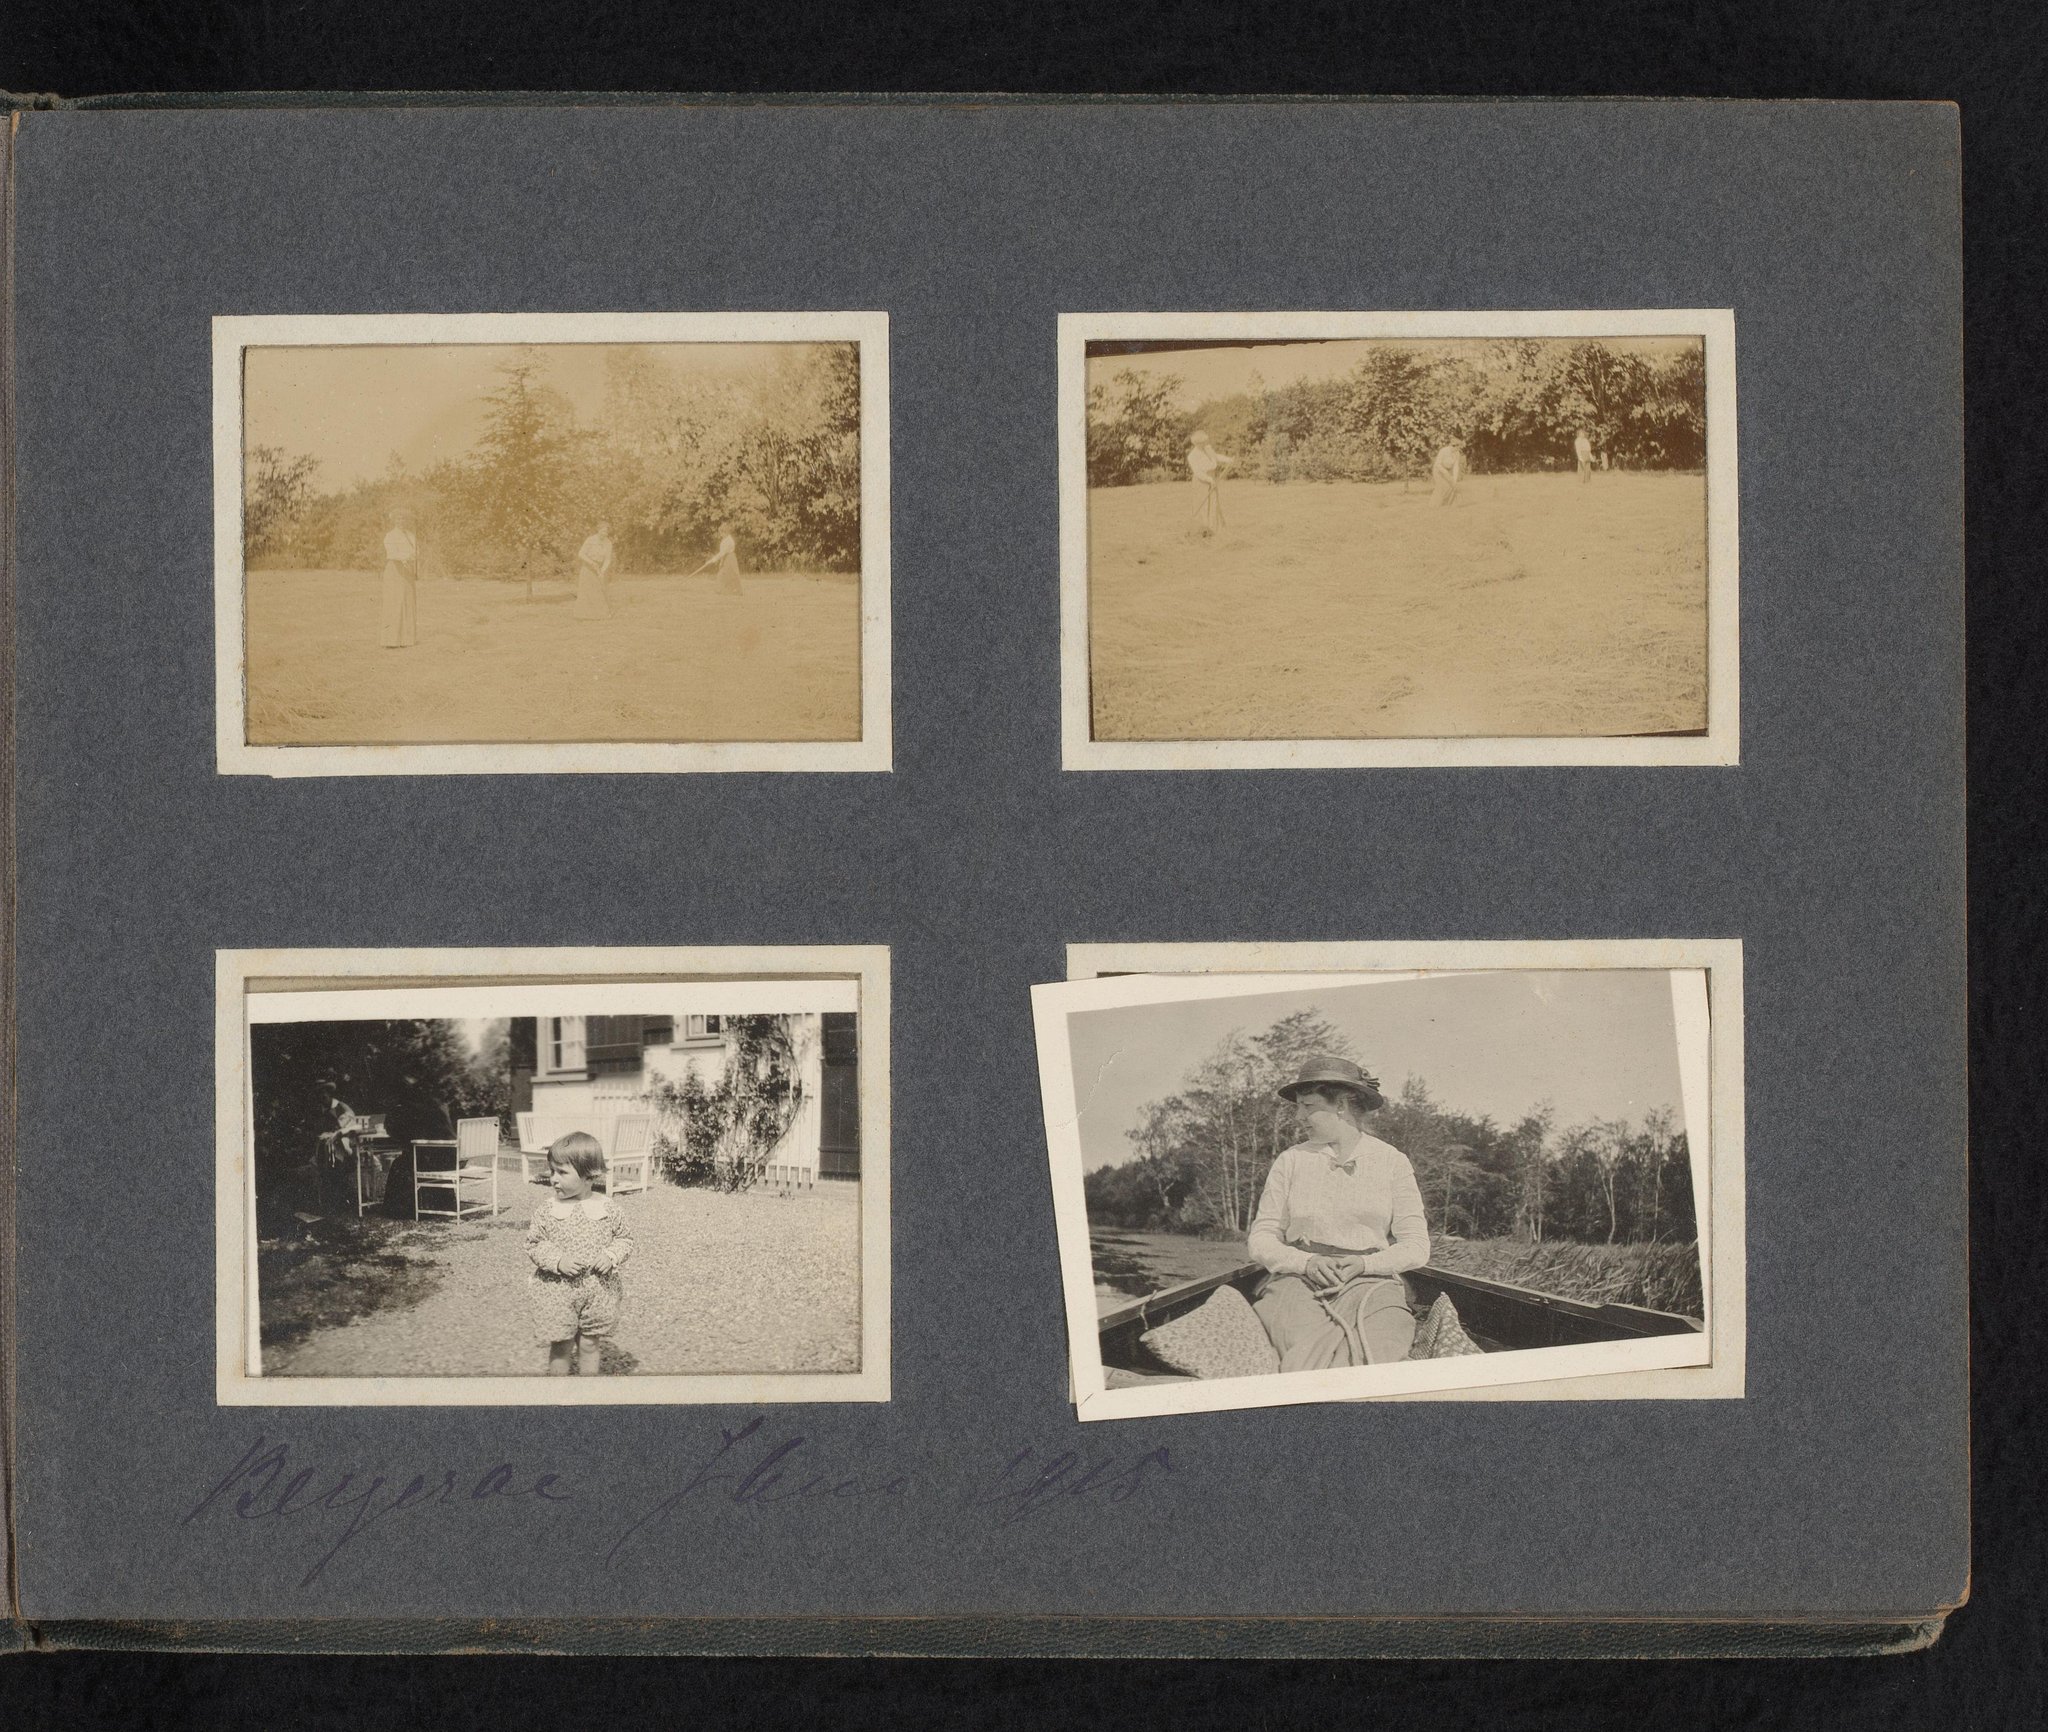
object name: album leaf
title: Vrouwen en een kind van de familie van den Berg in Bergerac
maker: hendrik herman van den berg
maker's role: amateurfotograaf, jurist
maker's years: 1875-1944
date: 1907-1915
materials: paper, cardboard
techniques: gelatin silver print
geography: bergerac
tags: family life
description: Deze foto's zijn onderdeel van een album.